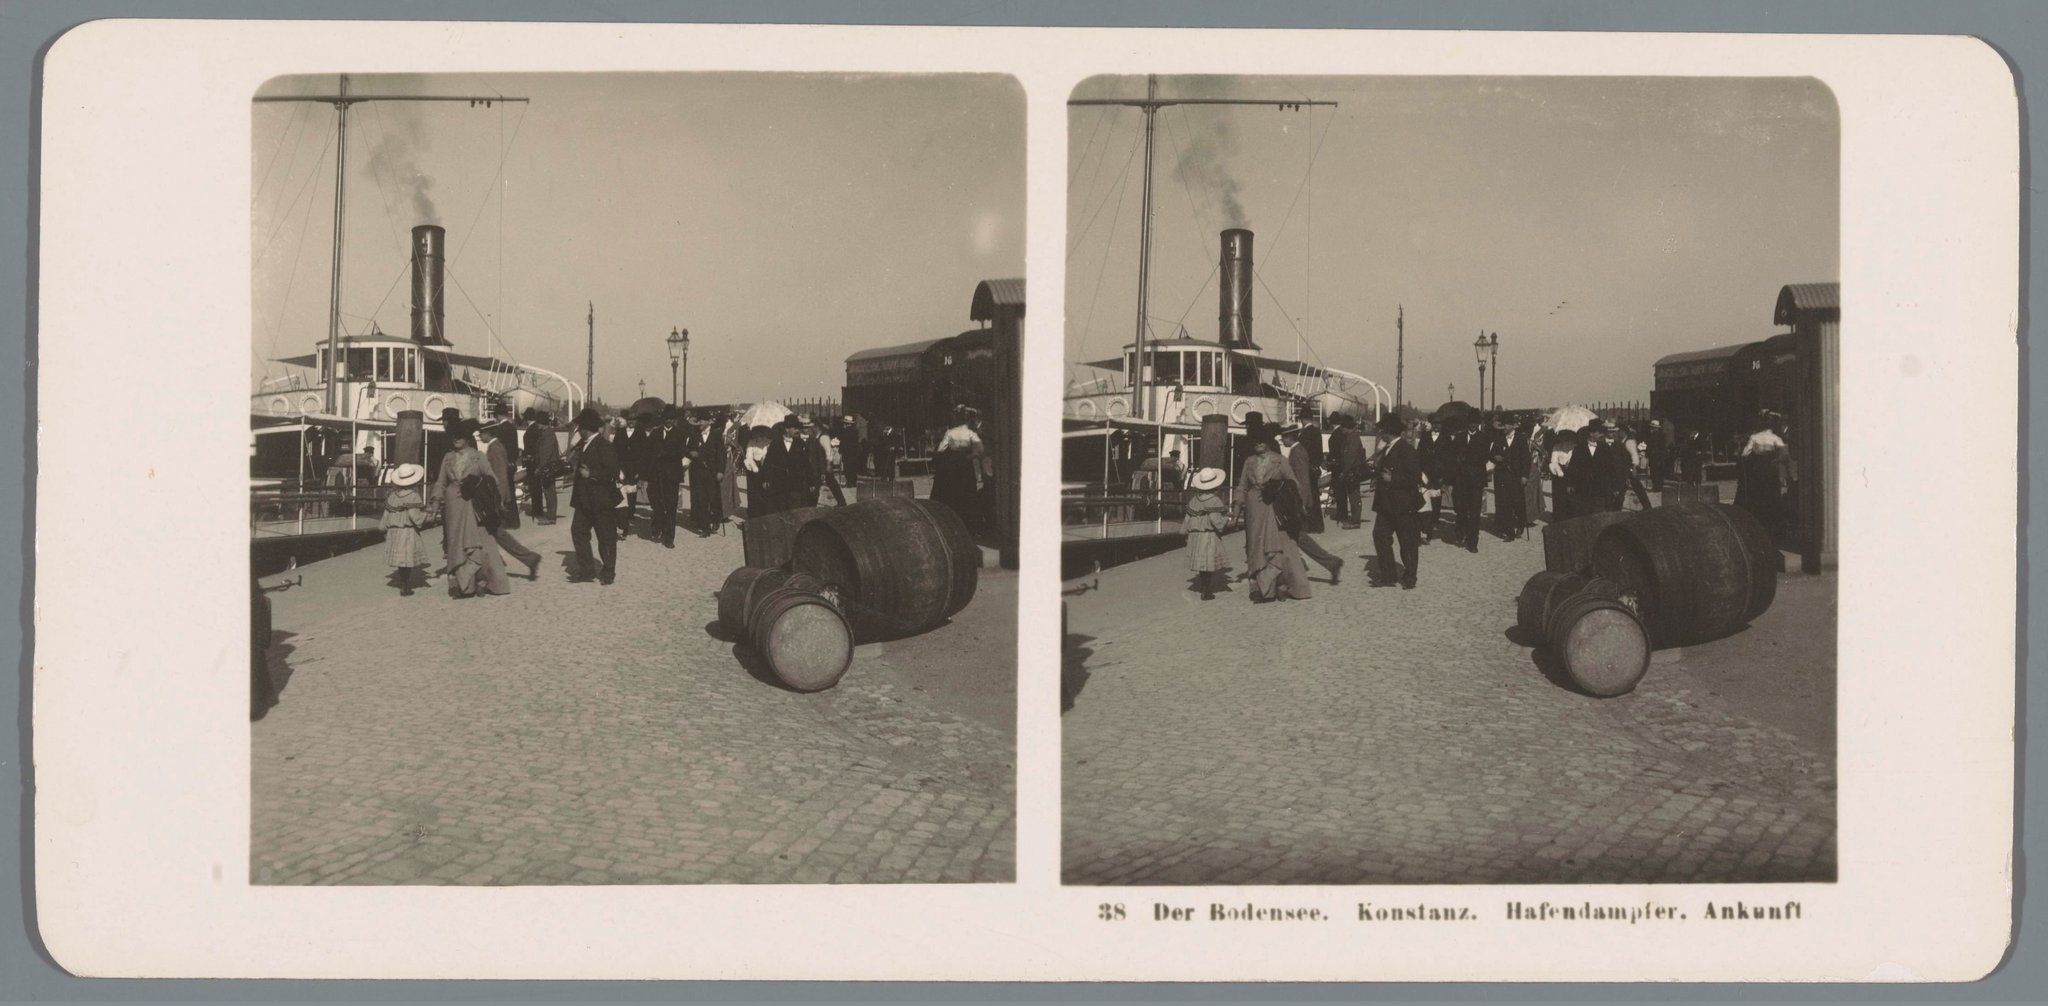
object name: stereograph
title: Der Bodensee. Konstanz. Hafendampfer. Ankunft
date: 1906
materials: cardboard, photographic support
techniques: gelatin silver print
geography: konstanz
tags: harbour, steamship, motorship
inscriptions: inscription: ‘Neue Photographische Gesellschaft A.-G. Steglitz-Berlin 1906.’, number: ‘38’